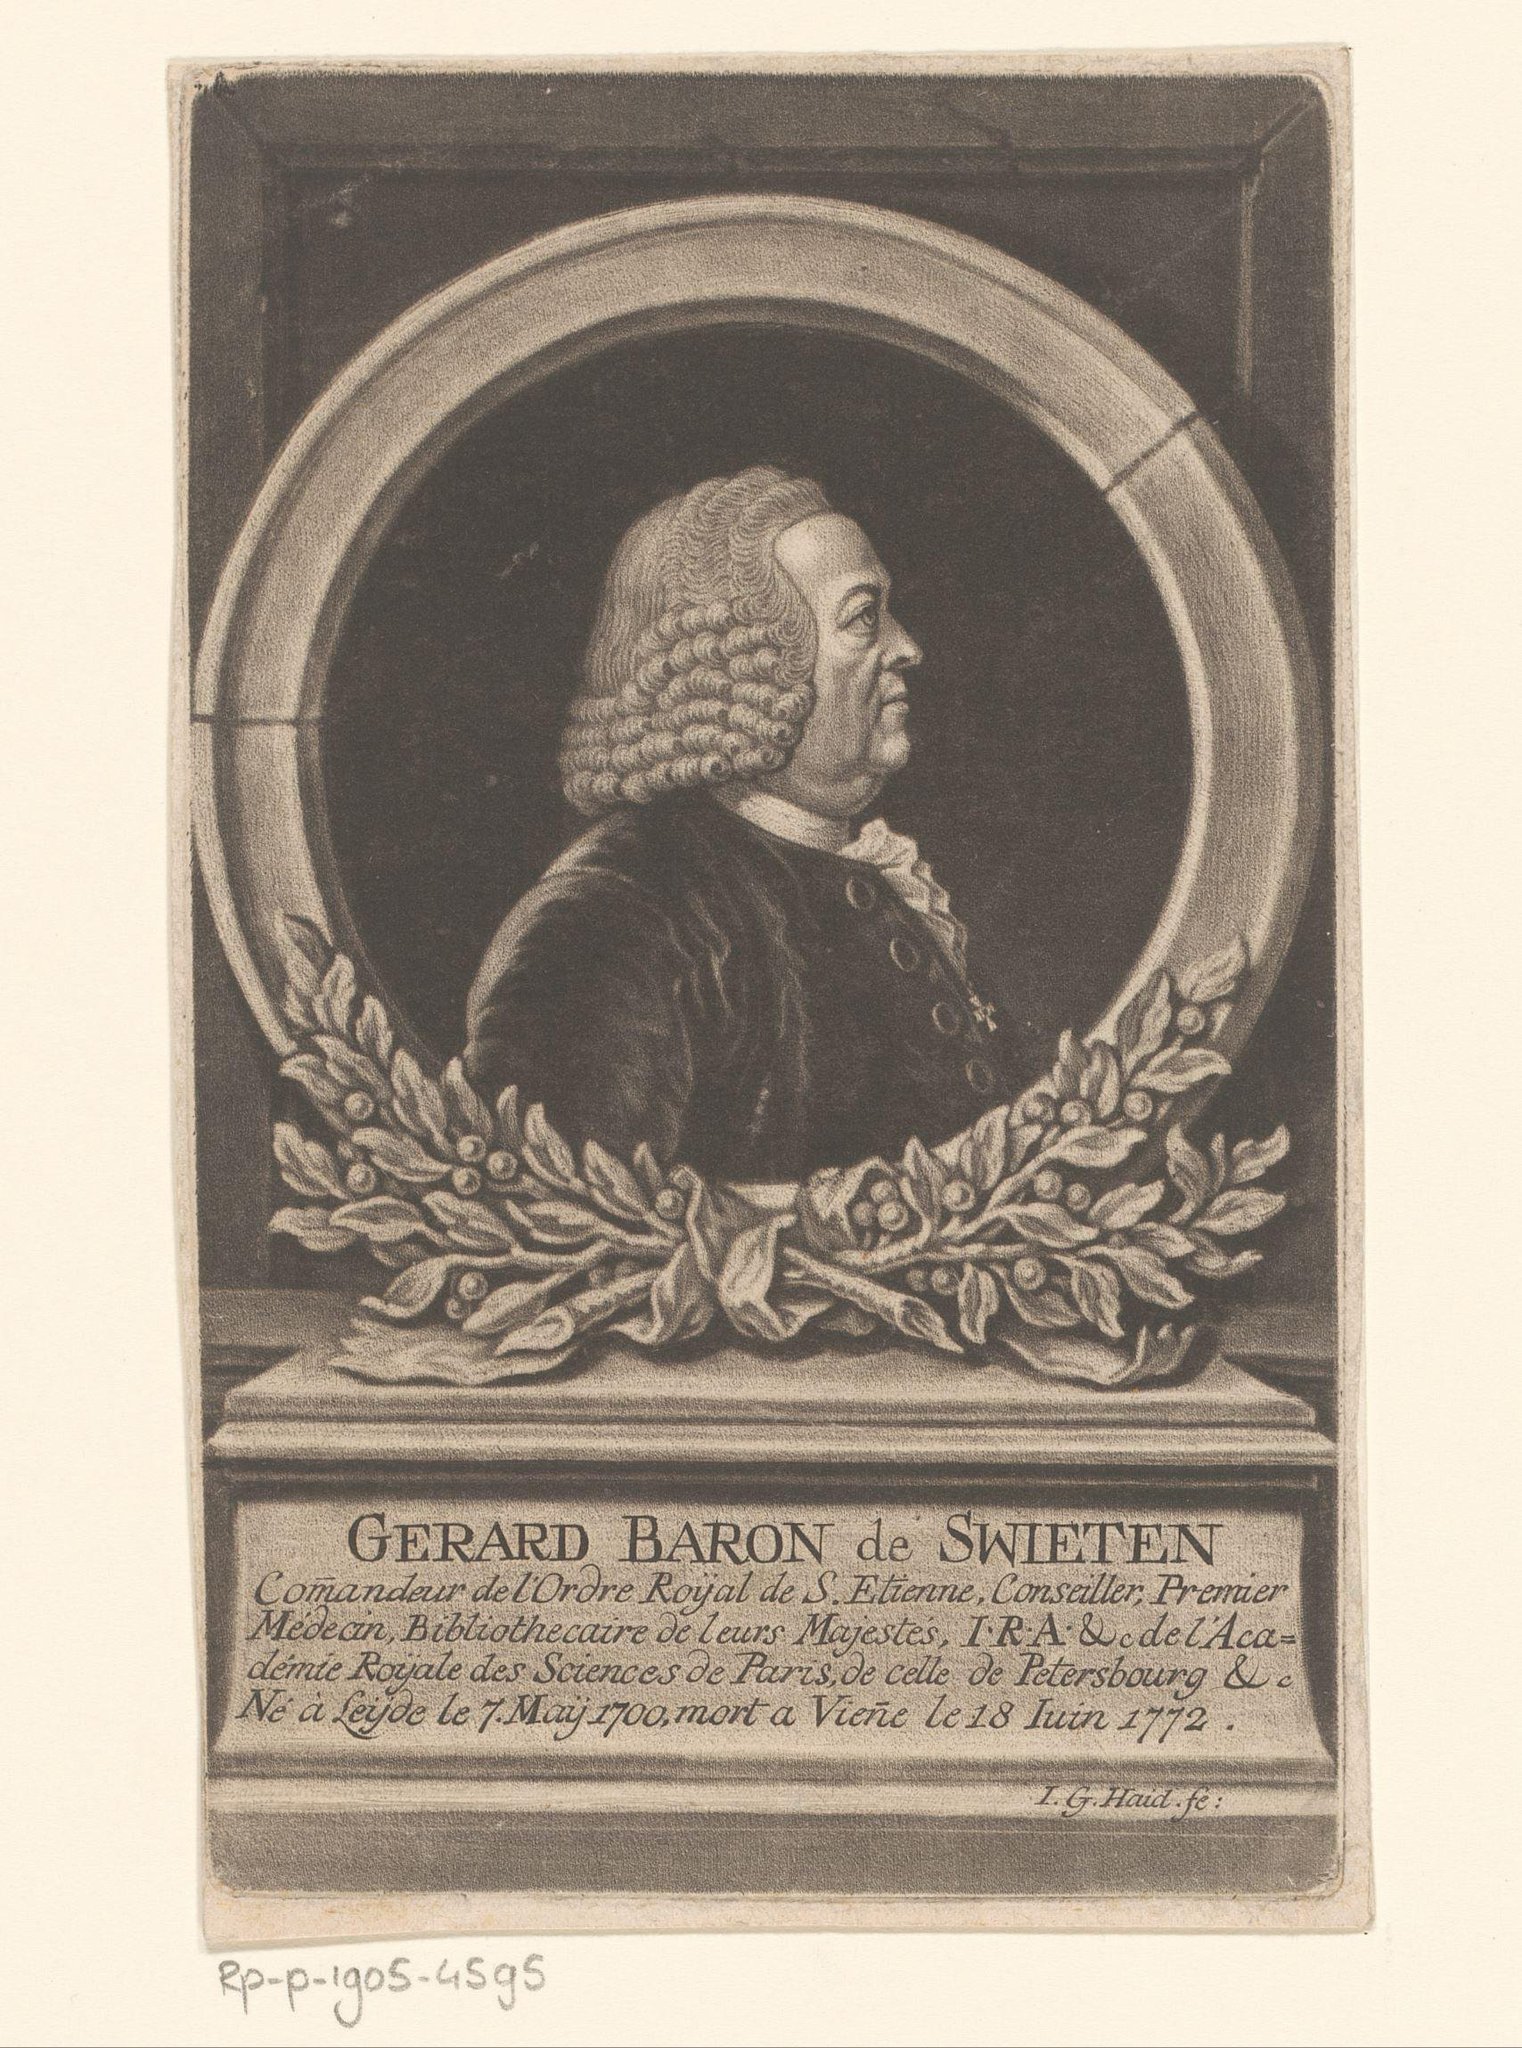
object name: print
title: Portret van Gerard van Swieten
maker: johann gottfried haid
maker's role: print maker, printer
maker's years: 1710-1776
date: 1772-1776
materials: paper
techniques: mezzotint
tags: leiden, vienna, trees: laurel (branch, stick), historical persons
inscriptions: collector's mark: Lugt 2228